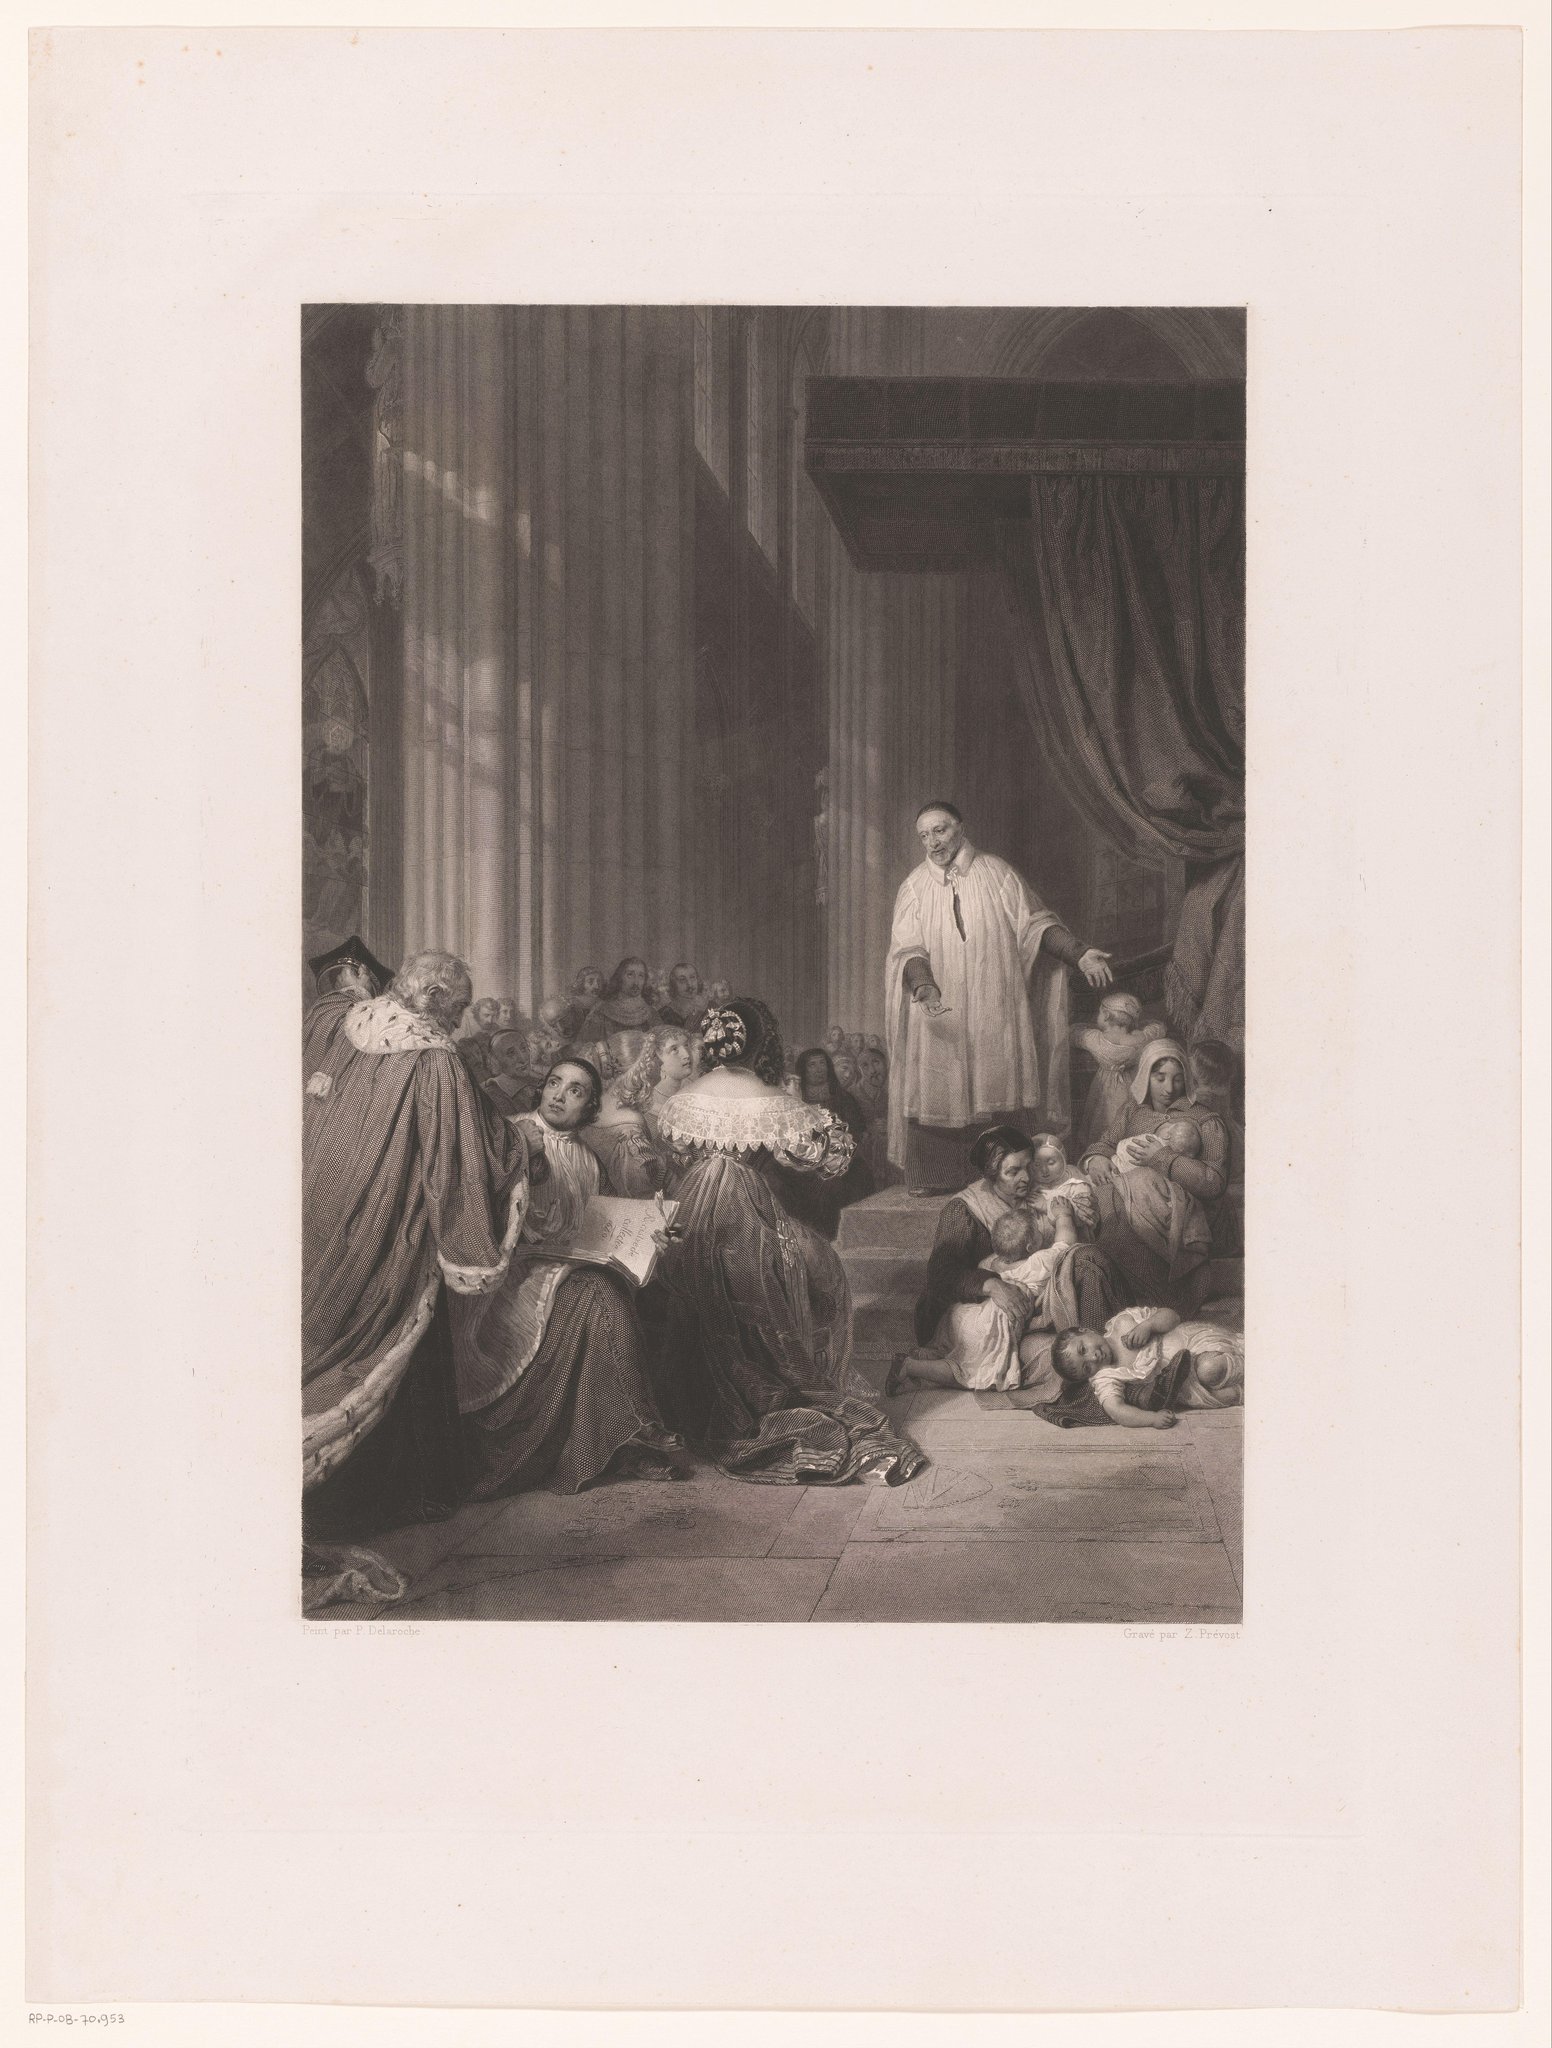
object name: print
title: Heilige Vincentius a Paulo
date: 1807-1861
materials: paper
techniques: engraving, etching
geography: france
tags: male saints (with name)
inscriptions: collector's mark: Lugt 12